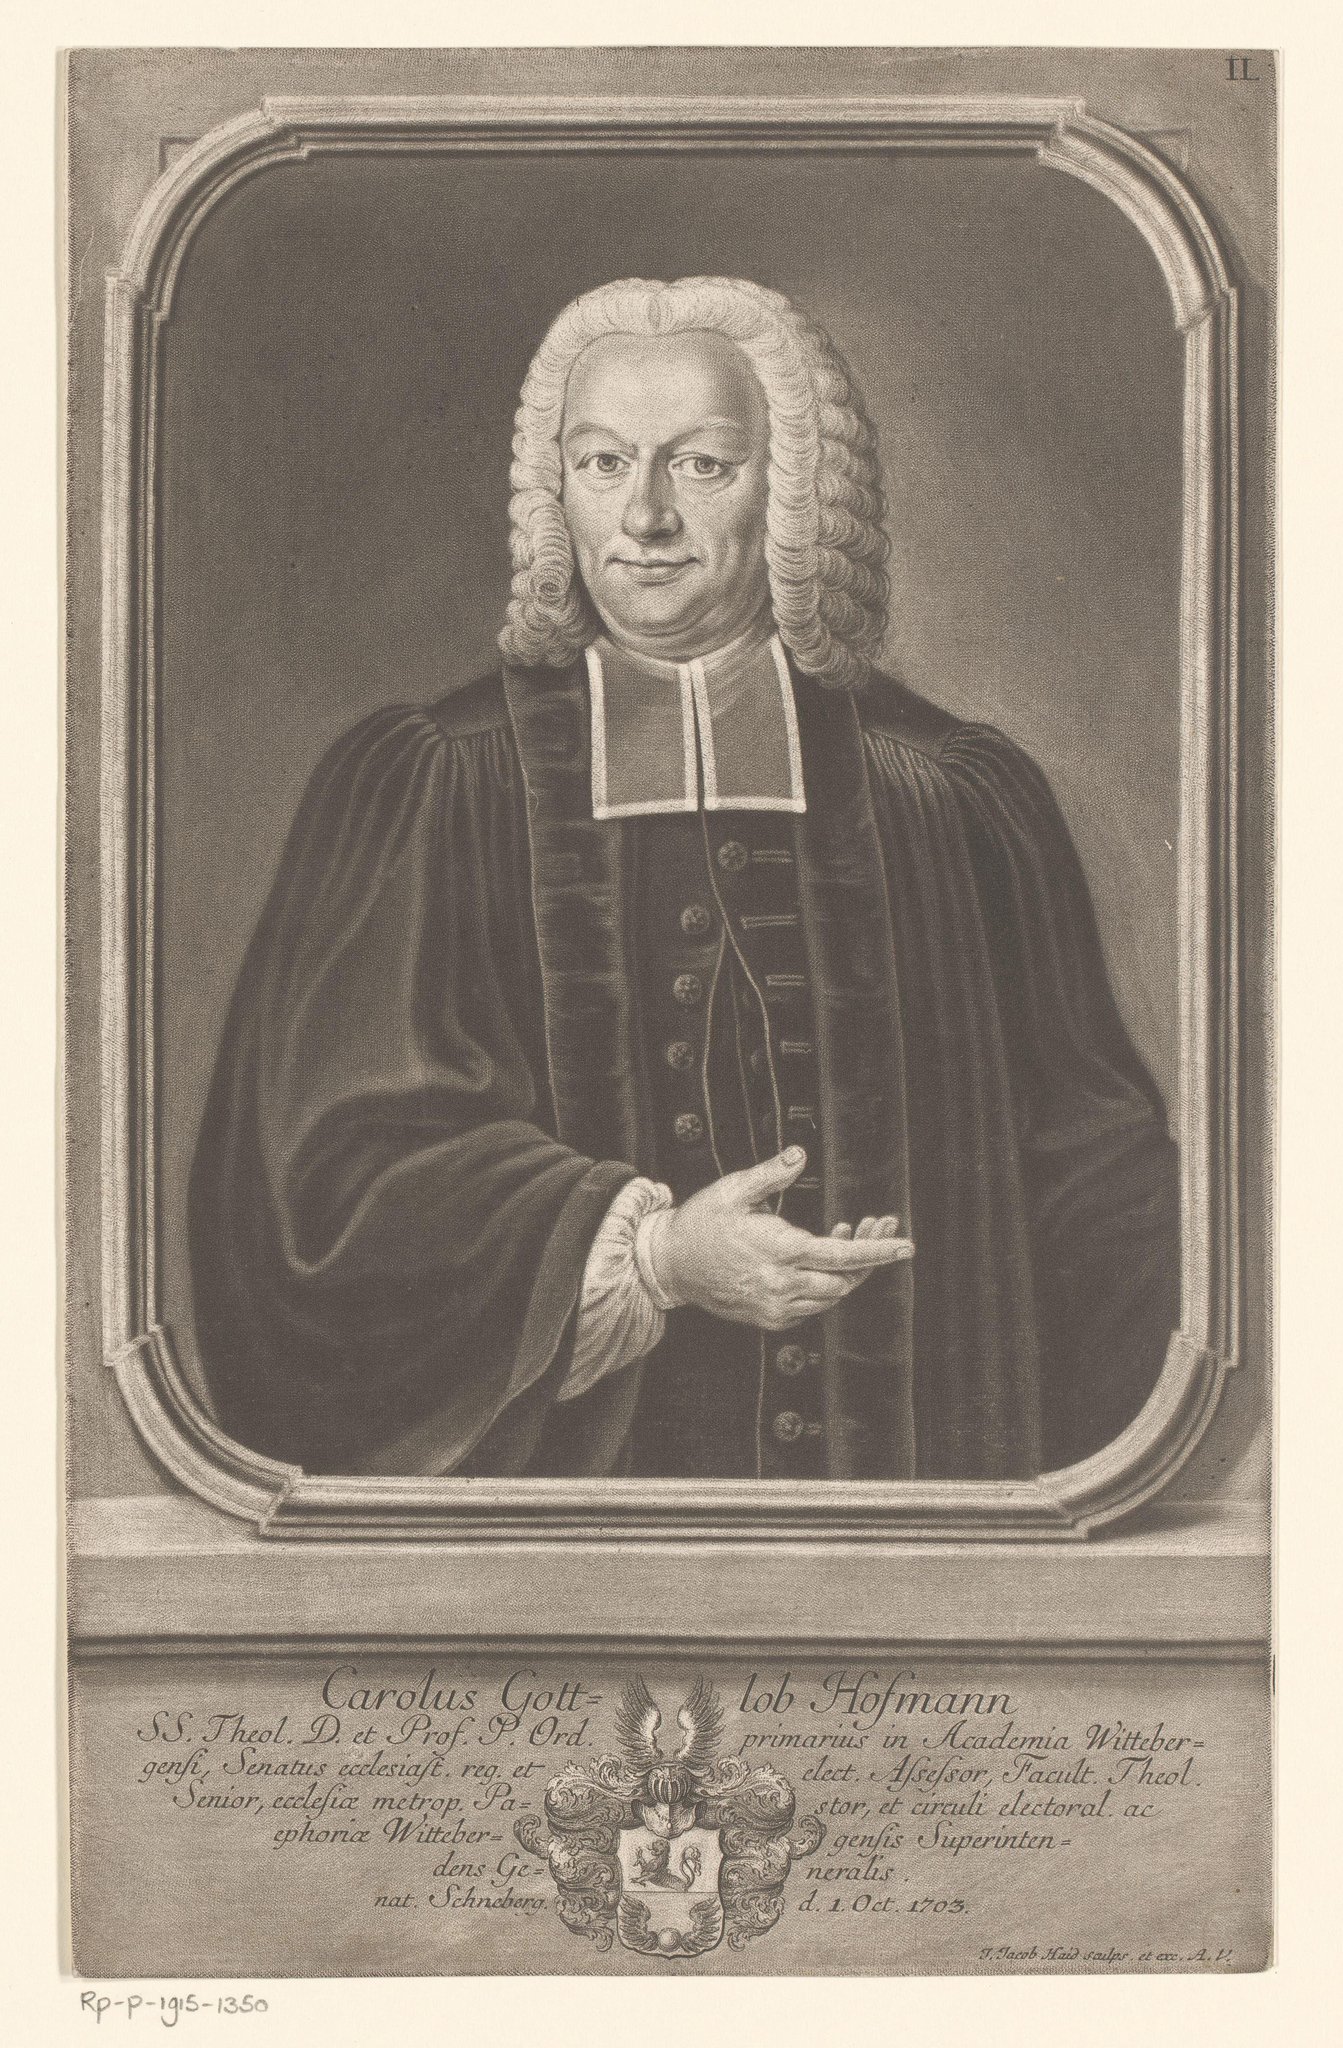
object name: print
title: Portret van Carl Gottlob Hofmann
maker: johann jacob haid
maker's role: print maker, publisher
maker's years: 1704-1767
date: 1757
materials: paper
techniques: etching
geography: augsburg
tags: historical persons, armorial bearing, heraldry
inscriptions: collector's mark: Lugt 2228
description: Prent gebruikt voor: Haid, Johann Jacob. Neue Sammlung von Bildnissen gelehrter (...) noch lebender Männer. Augsburg: Johann Jacob Haid, 1757.